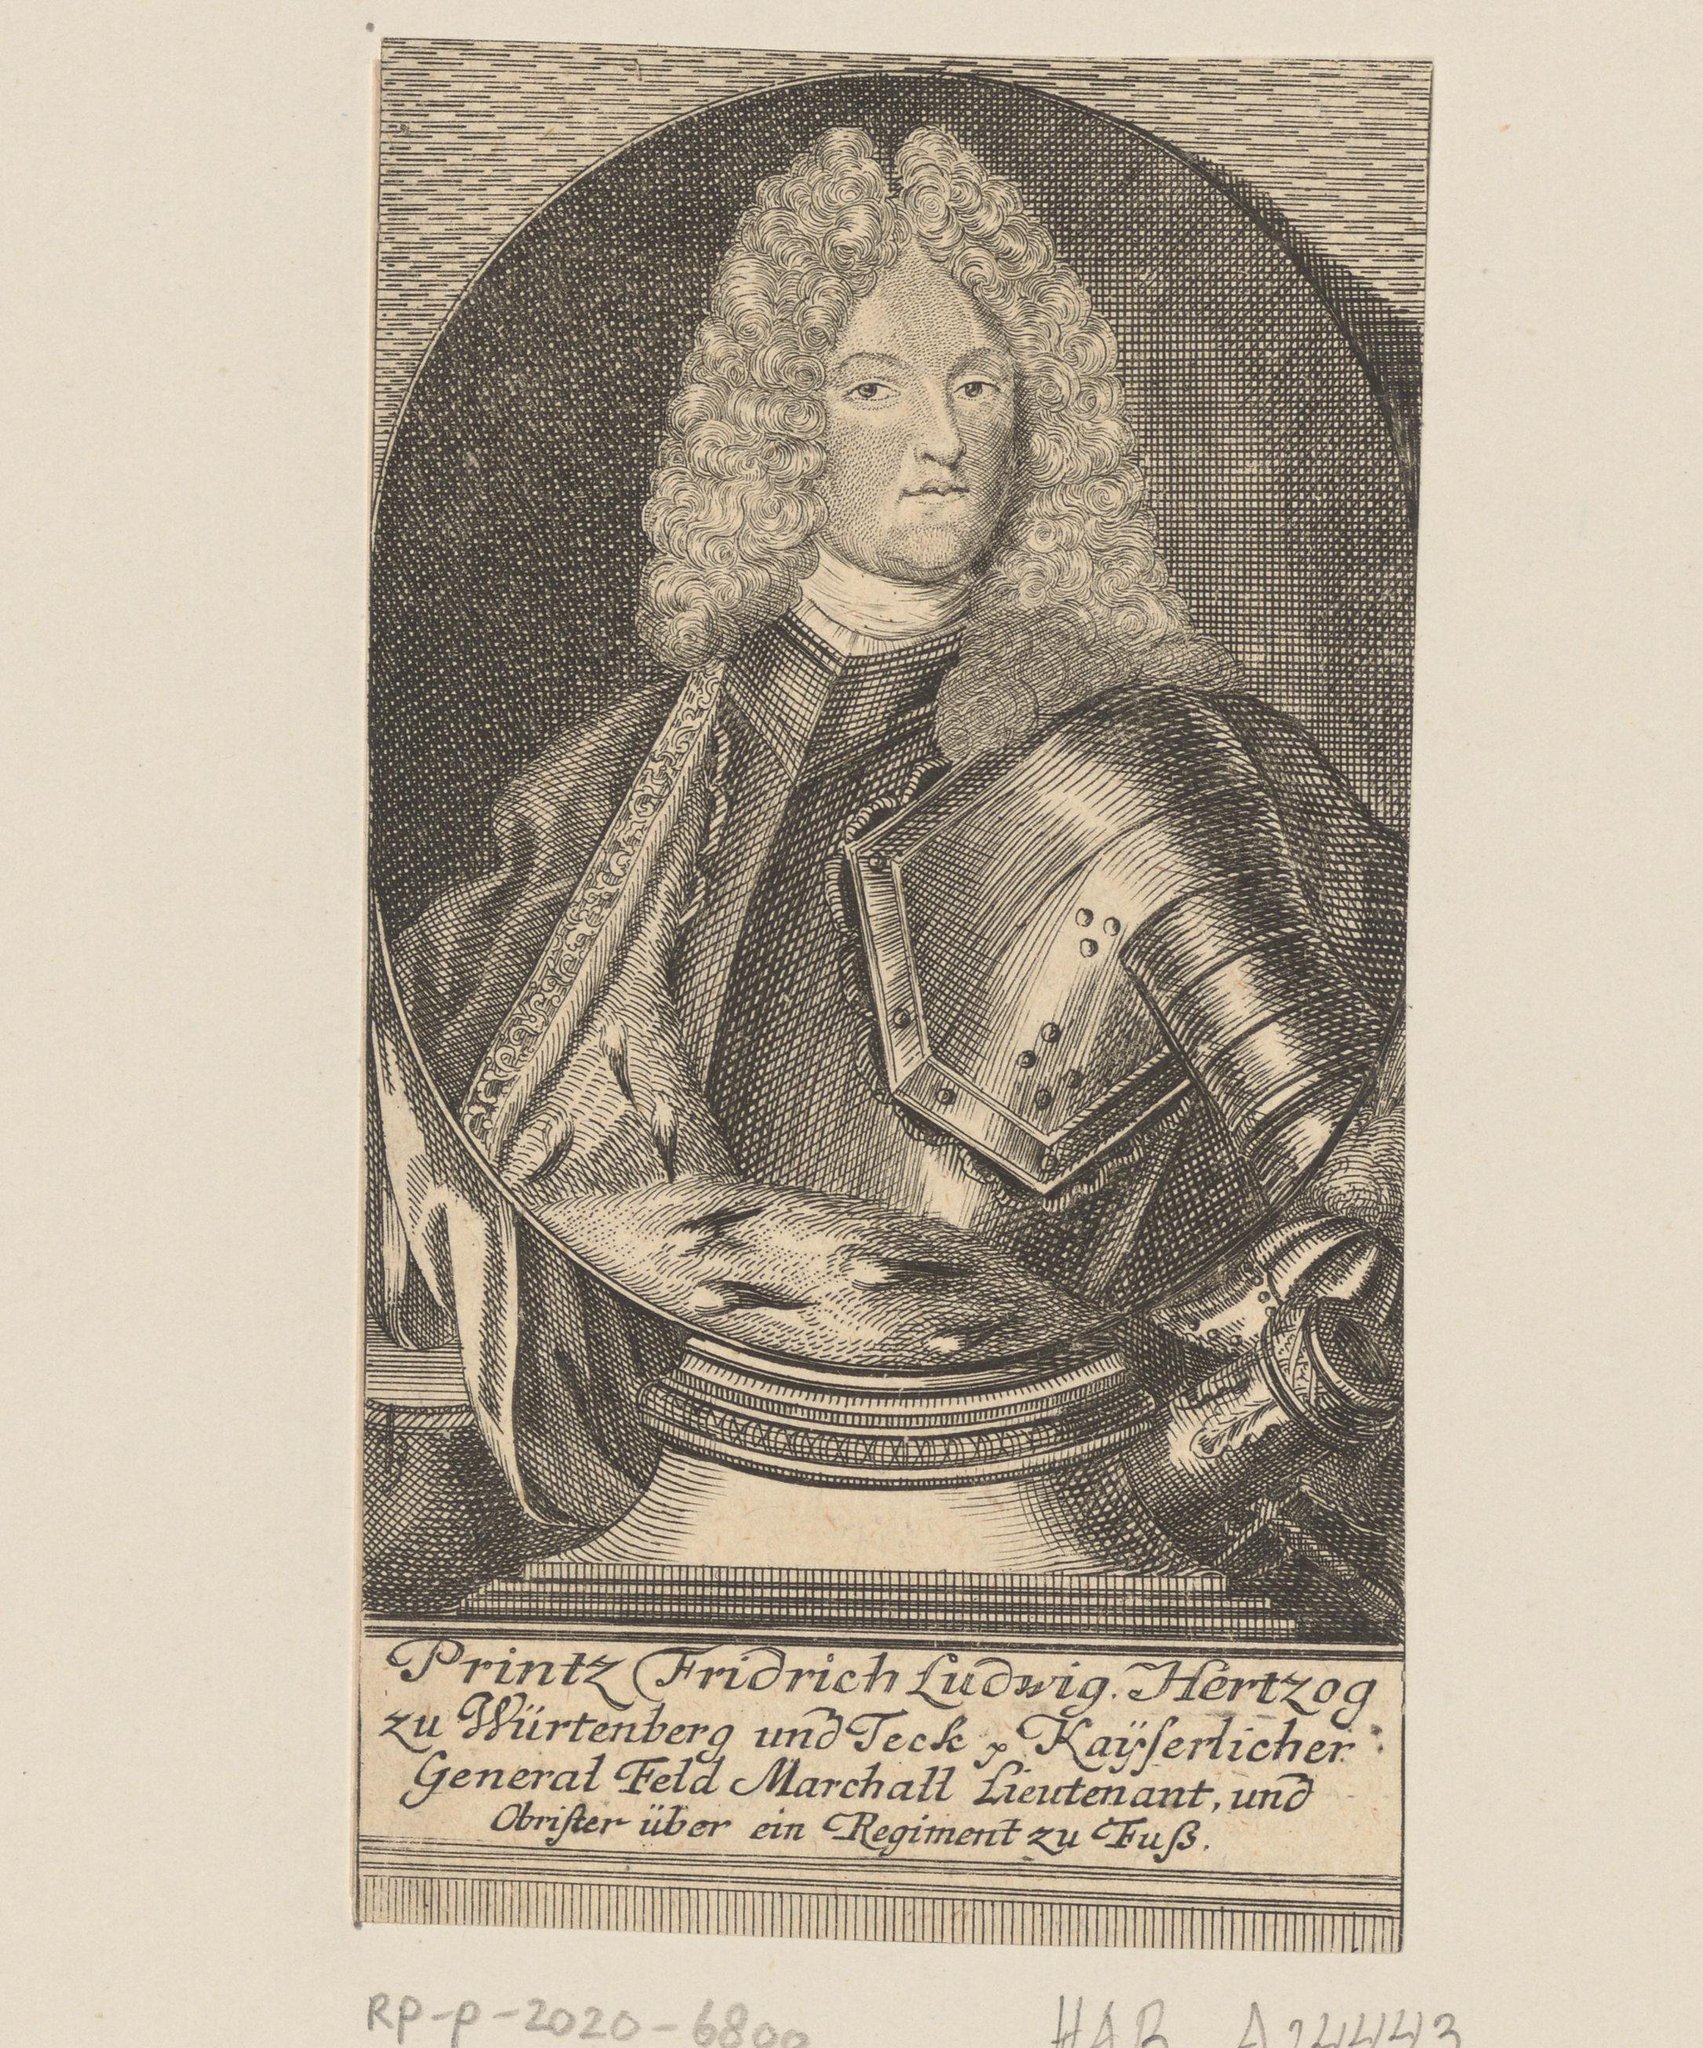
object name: print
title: Portret van Frederik Lodewijk van Württemberg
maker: Anonymous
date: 1718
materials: paper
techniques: engraving, etching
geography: germany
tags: ornament ~ medallion, armour, historical persons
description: Prent waarschijnlijk uit: Die Europäische staats-Cantzley (...), vol. 30, 1718.